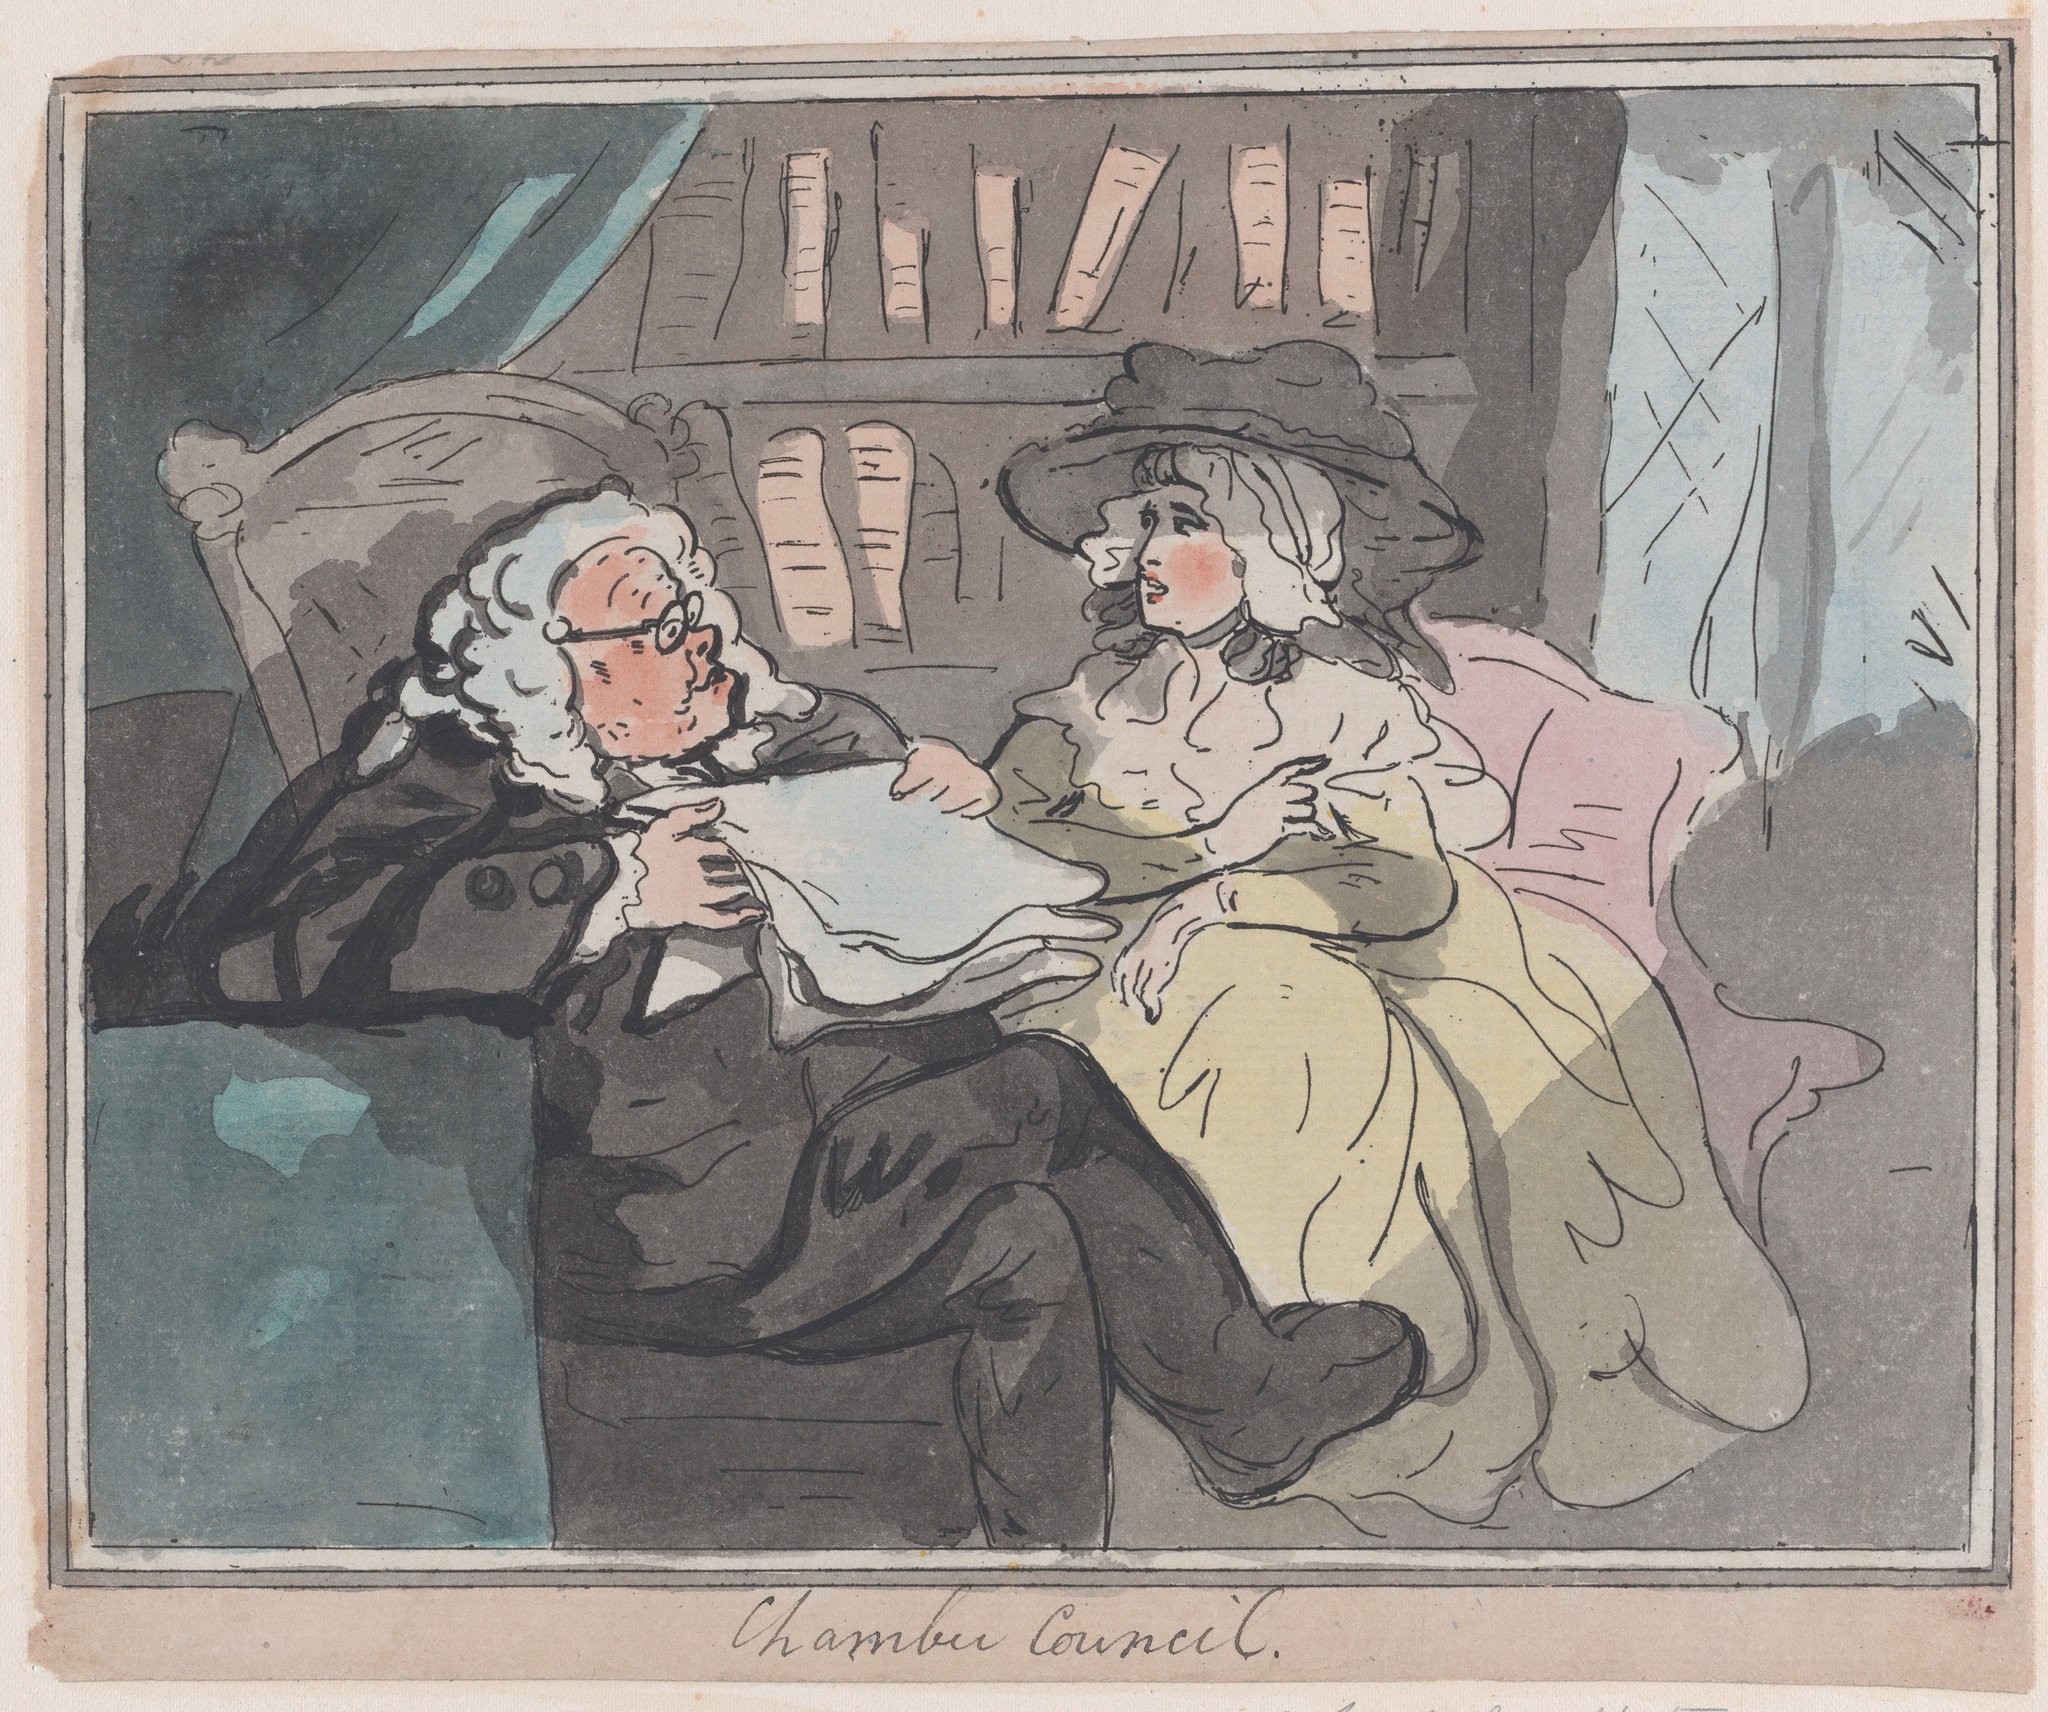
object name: print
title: A Counselor's Opinion After He Had Retired From Practice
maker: thomas rowlandson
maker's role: artist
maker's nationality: british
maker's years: 1757-1827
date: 1780-1794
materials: watercolor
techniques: etching, wash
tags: satire,men,women